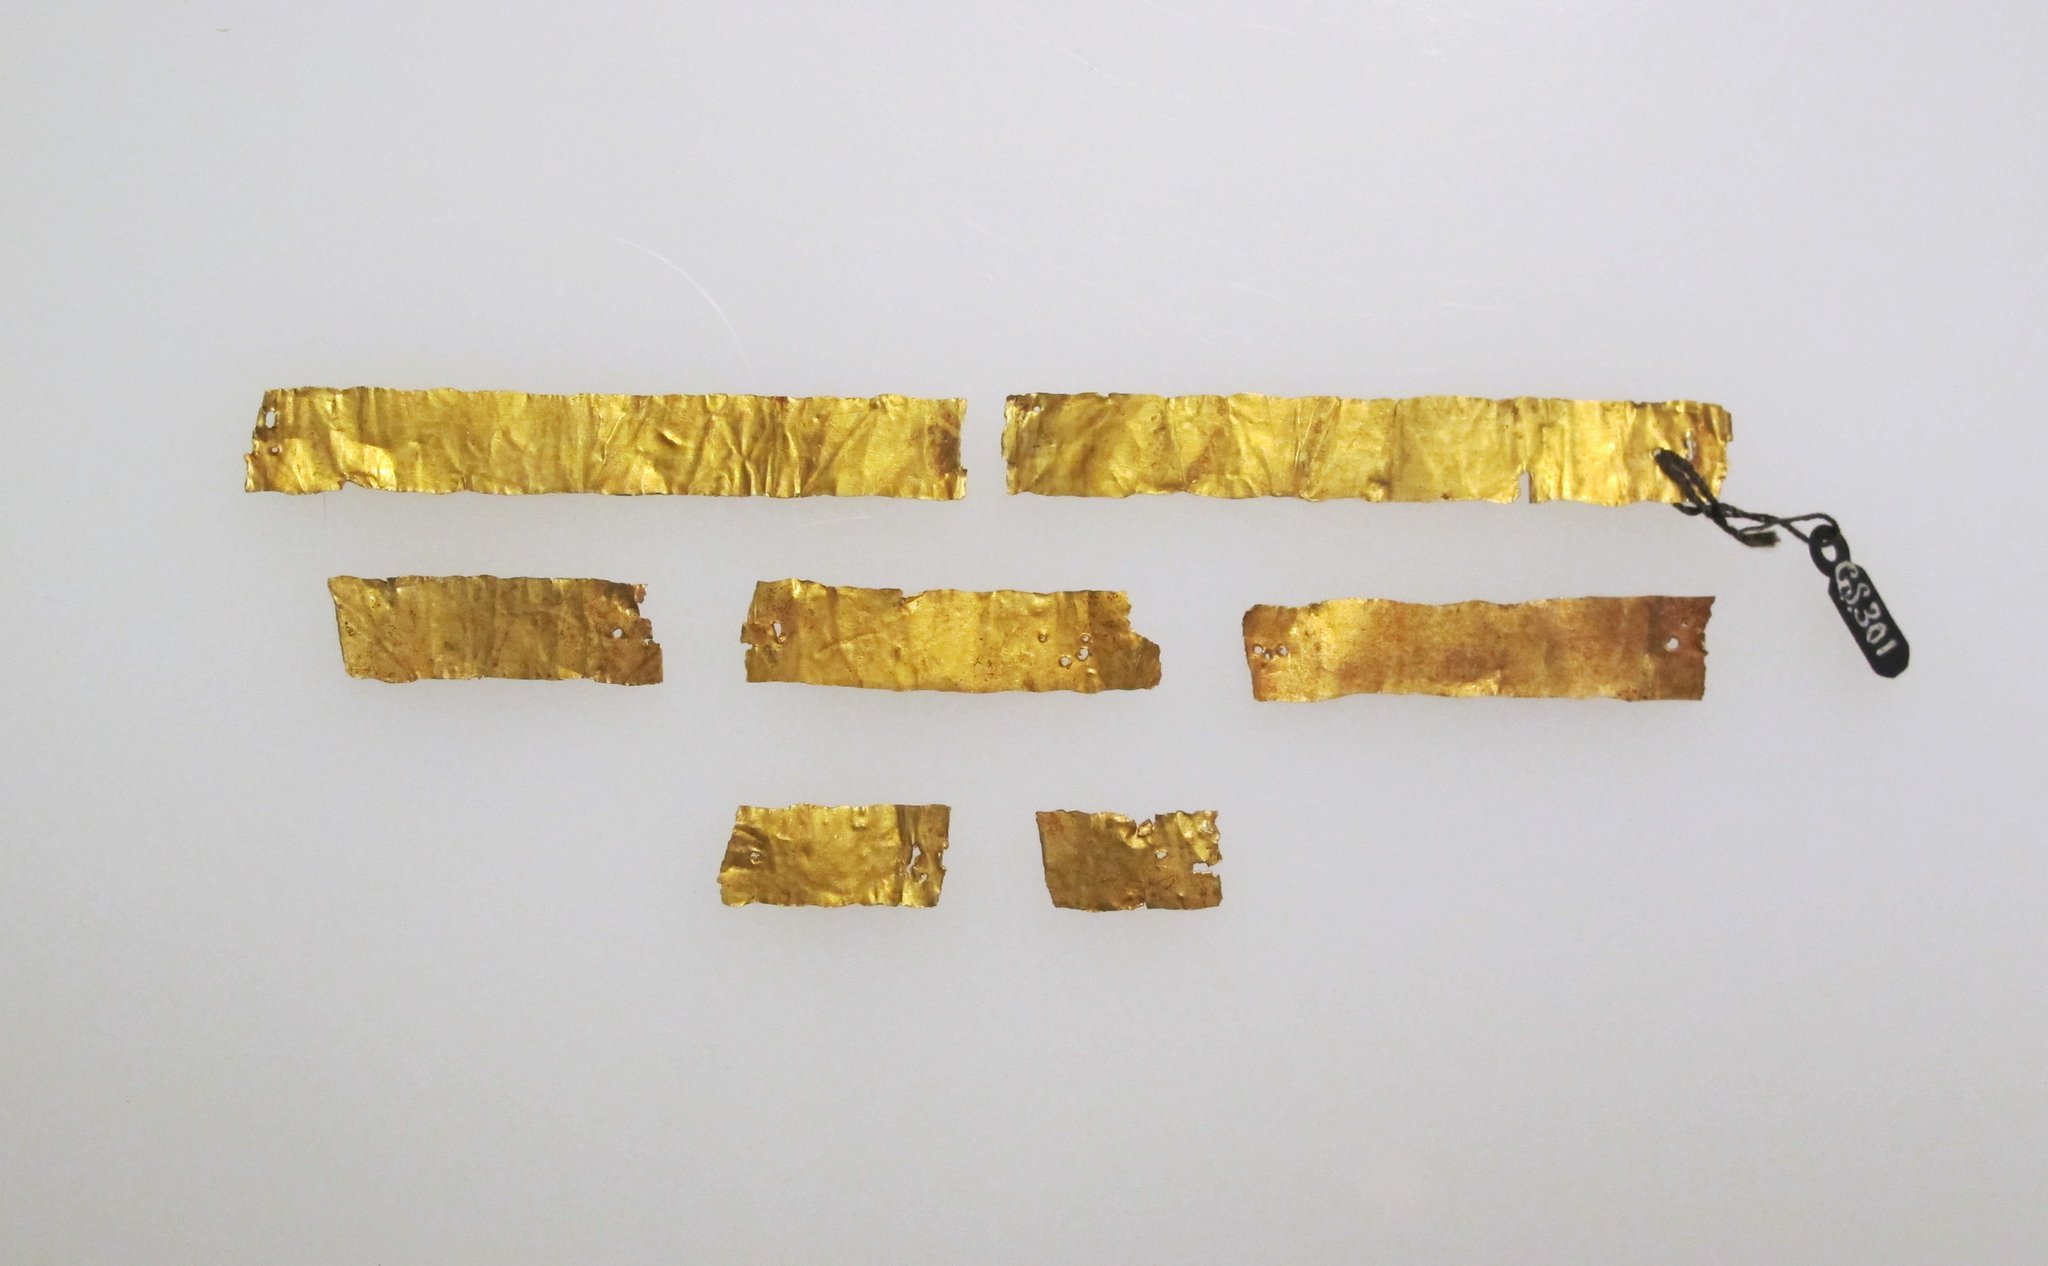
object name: wreath fillet, funerary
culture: greek or roman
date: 7000 BCE-330 CE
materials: gold